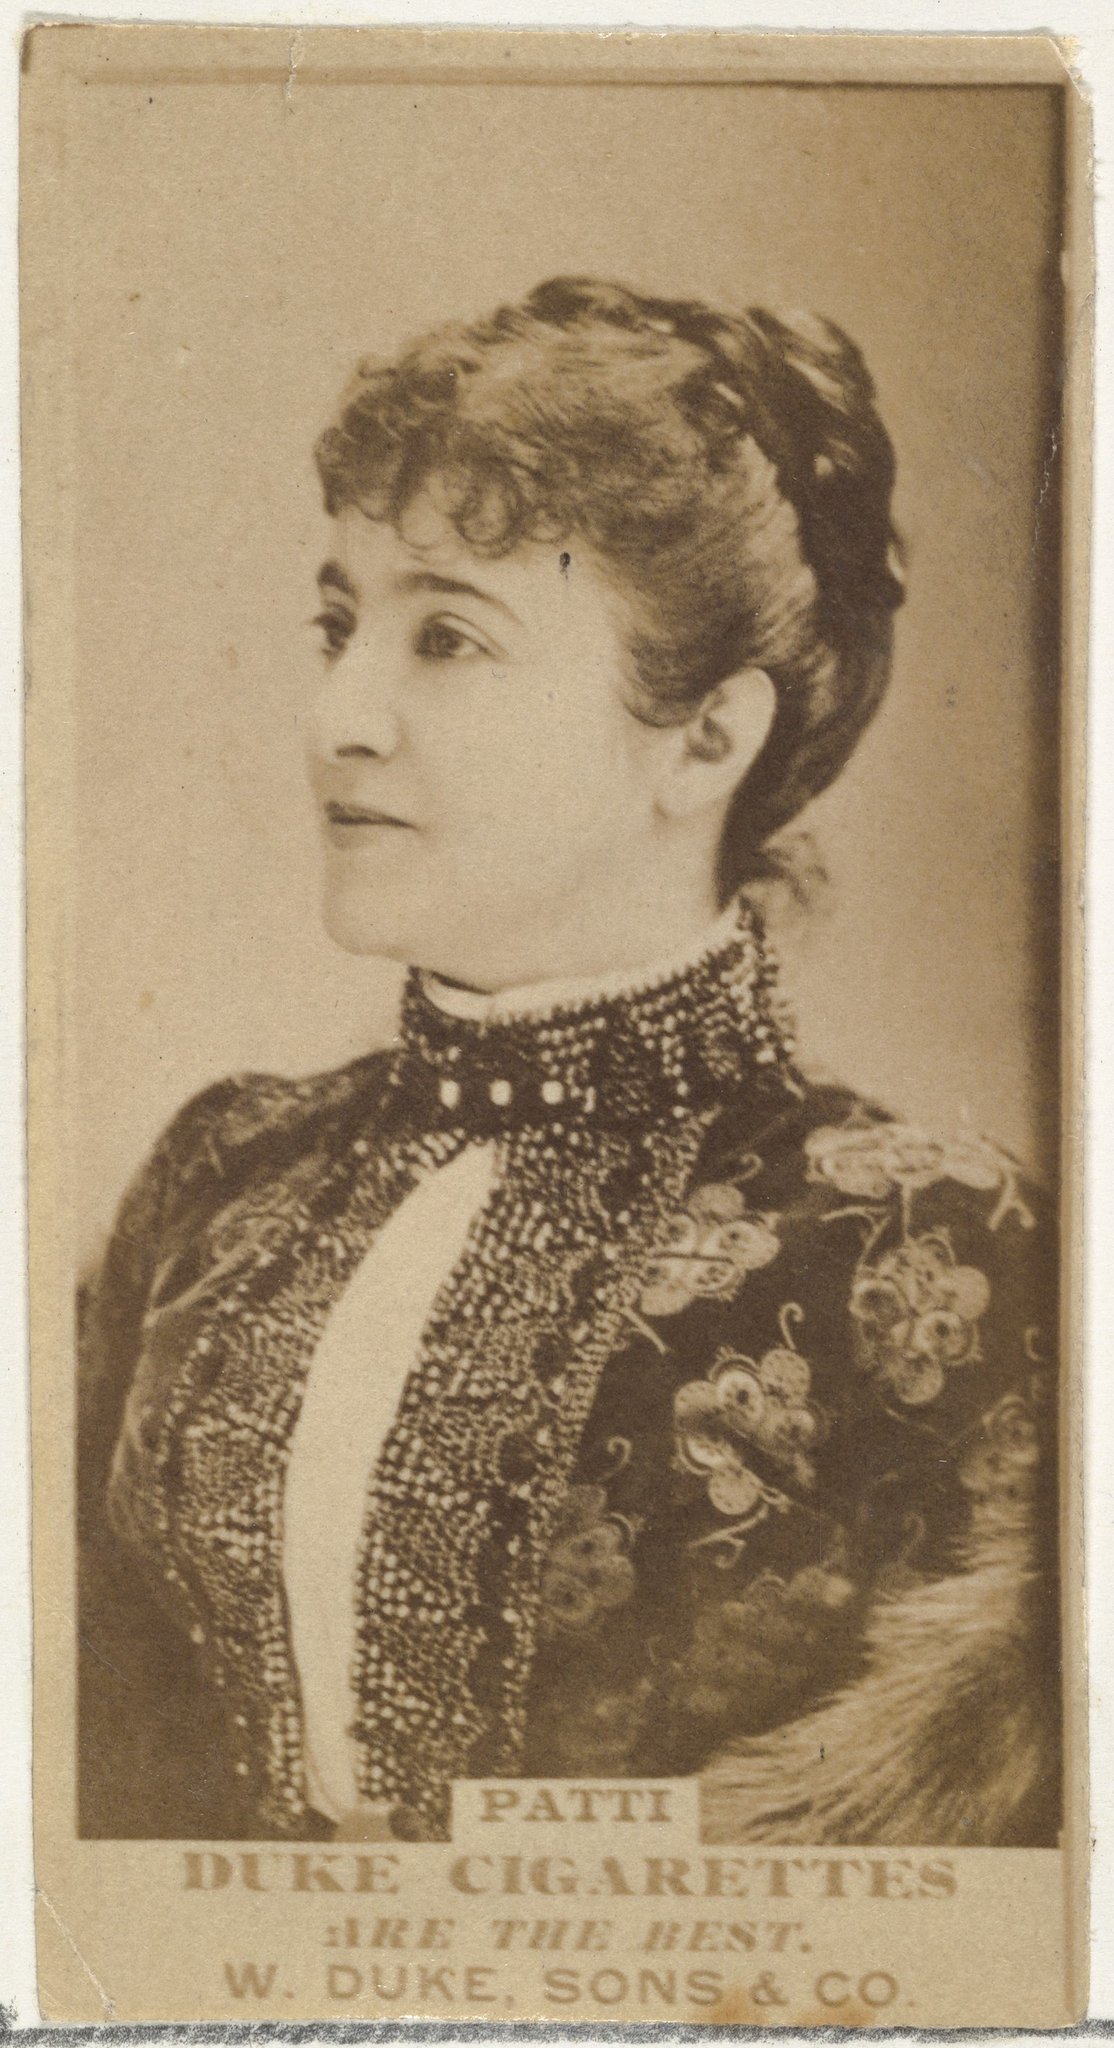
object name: photograph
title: Miss Patti, from the Actors and Actresses series (N145-7) issued by Duke Sons & Co. to promote Duke Cigarettes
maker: w. duke, sons & co.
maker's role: publisher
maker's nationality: american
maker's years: 1870-1920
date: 1880-1889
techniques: albumen silver print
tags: portraits,women,actresses